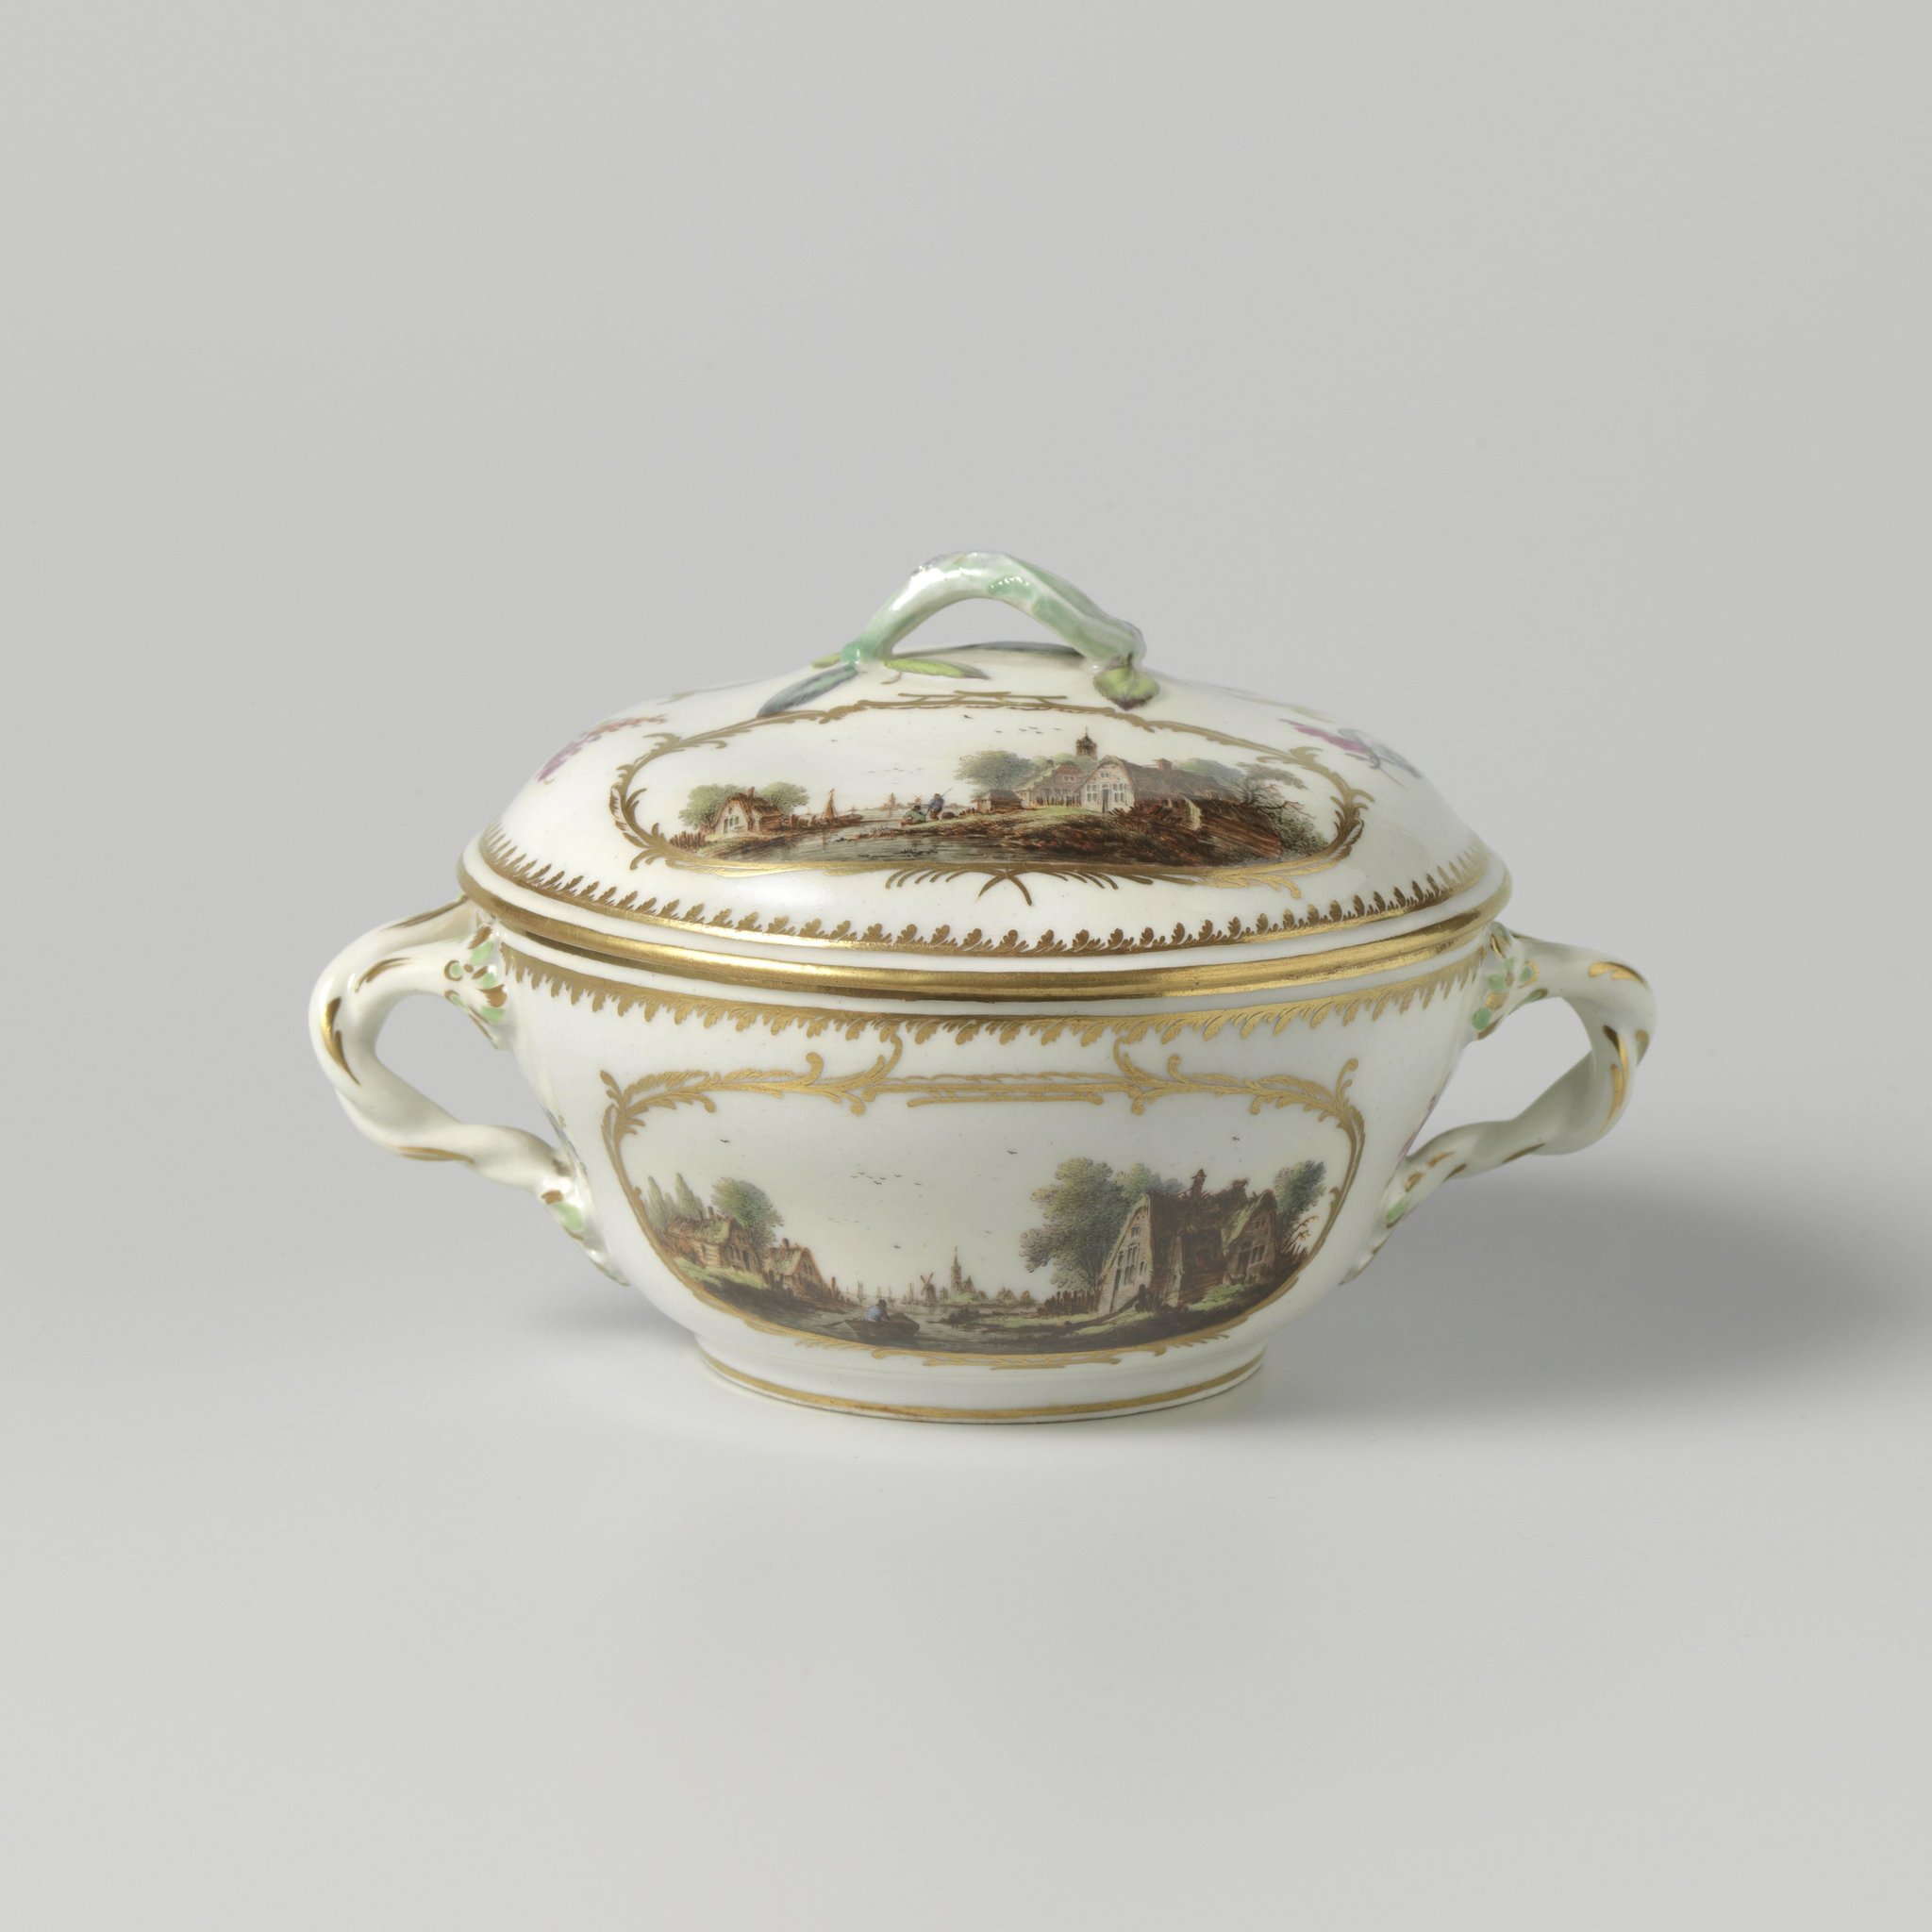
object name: tureen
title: Tureen and stand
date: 1778-1782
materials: porcelain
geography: loosdrecht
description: Manufactuur Oud-Loosdrecht Loosdrecht, c. 1778–1782 hard-paste porcelain